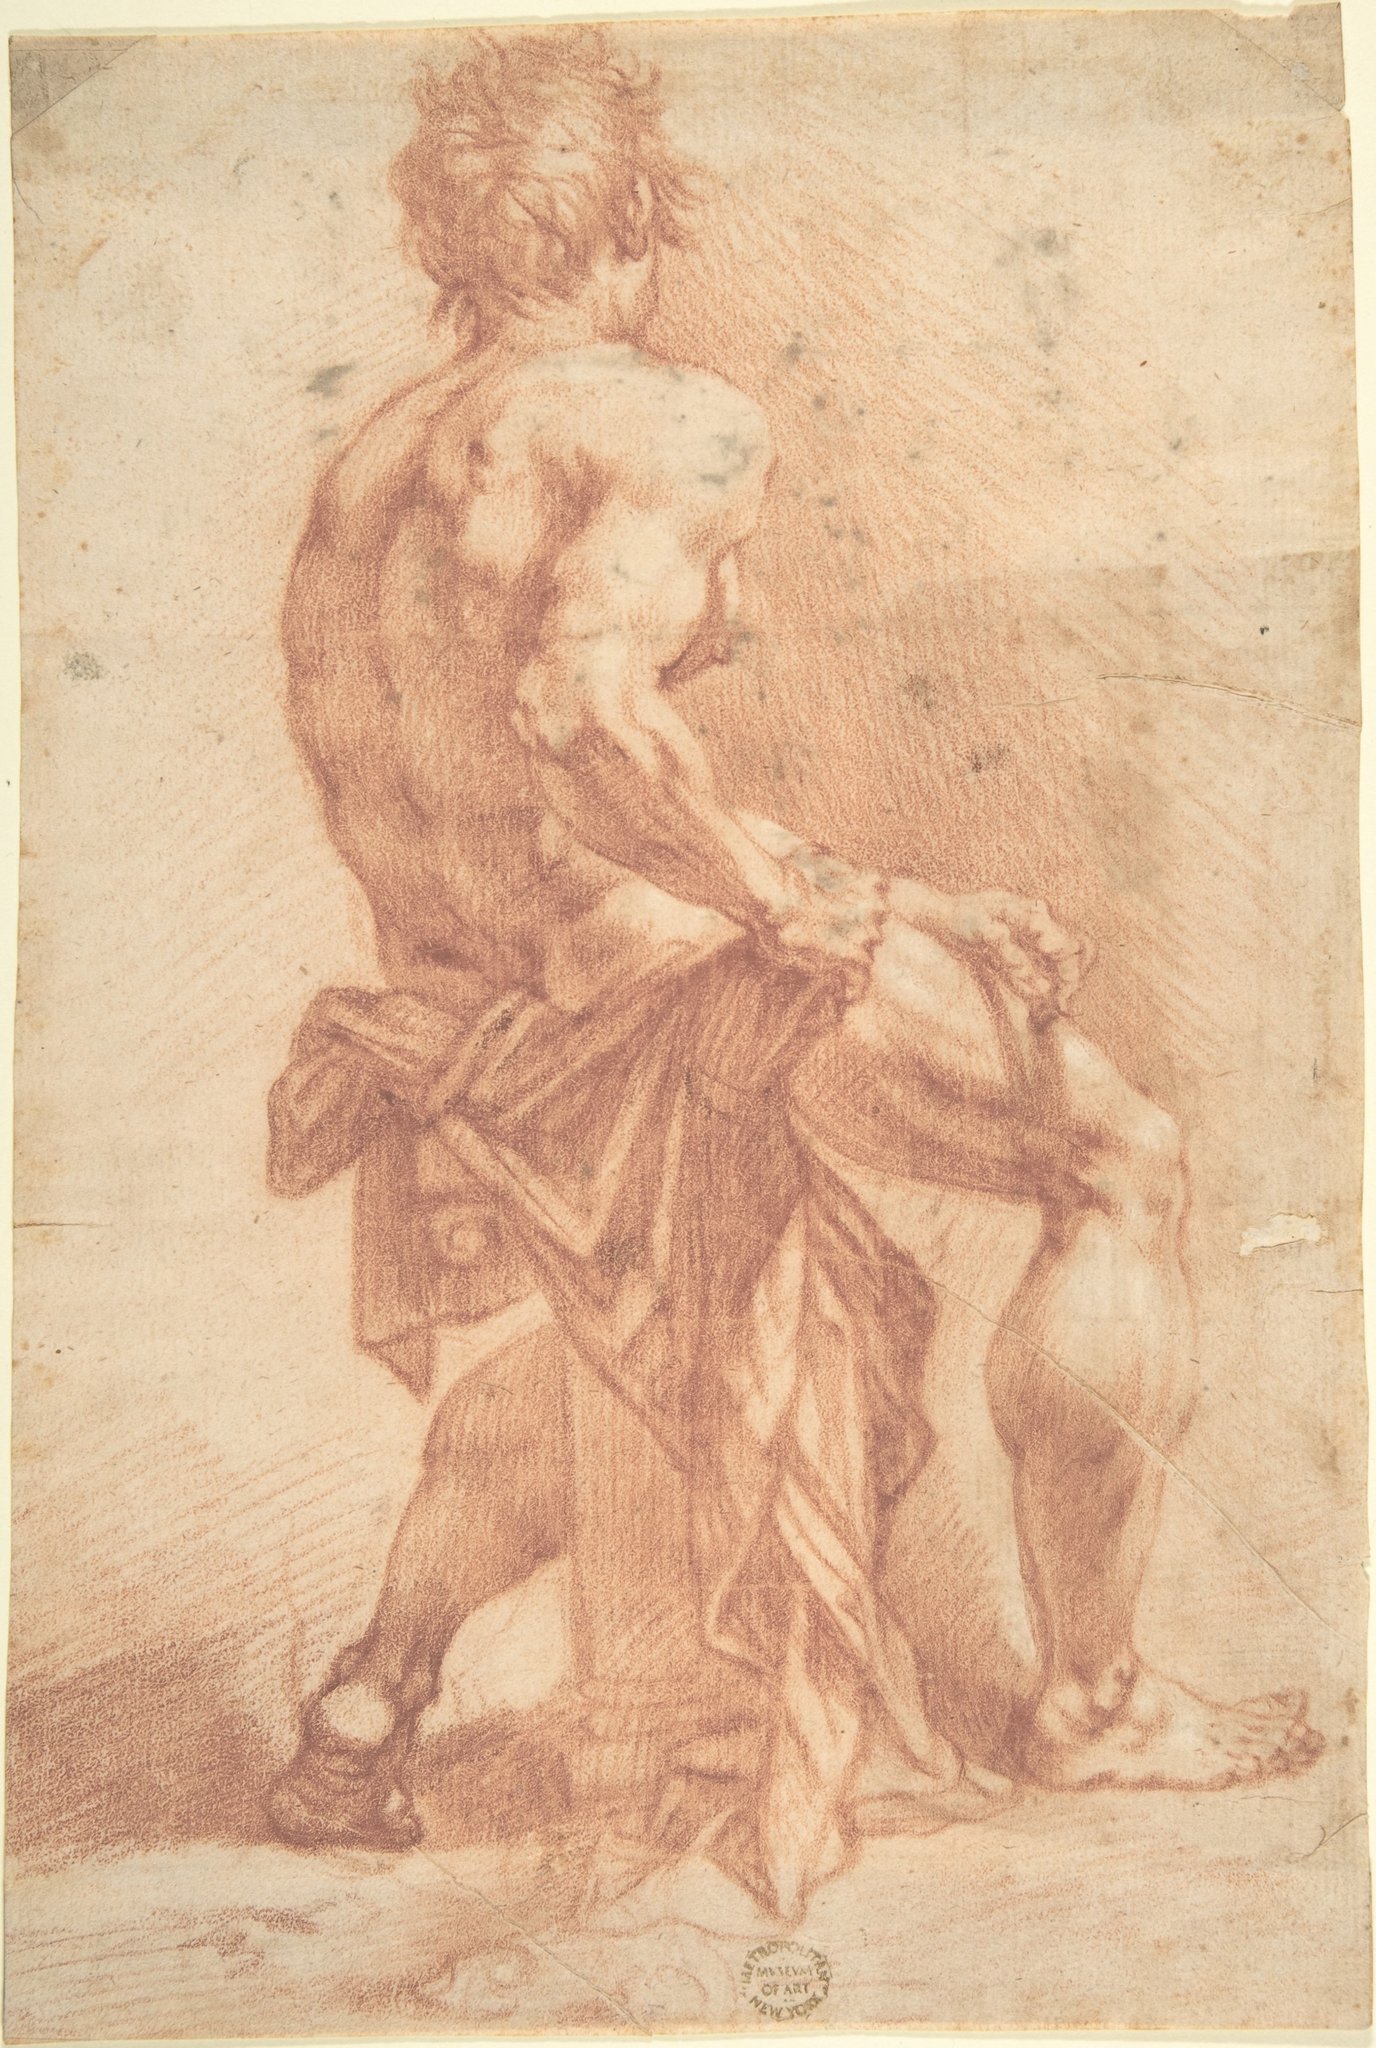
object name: drawing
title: Male Figure Seated on a Column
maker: anonymous, italian, 18th century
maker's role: artist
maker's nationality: italian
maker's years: 1700-1800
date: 1701-1800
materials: chalk, paper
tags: men